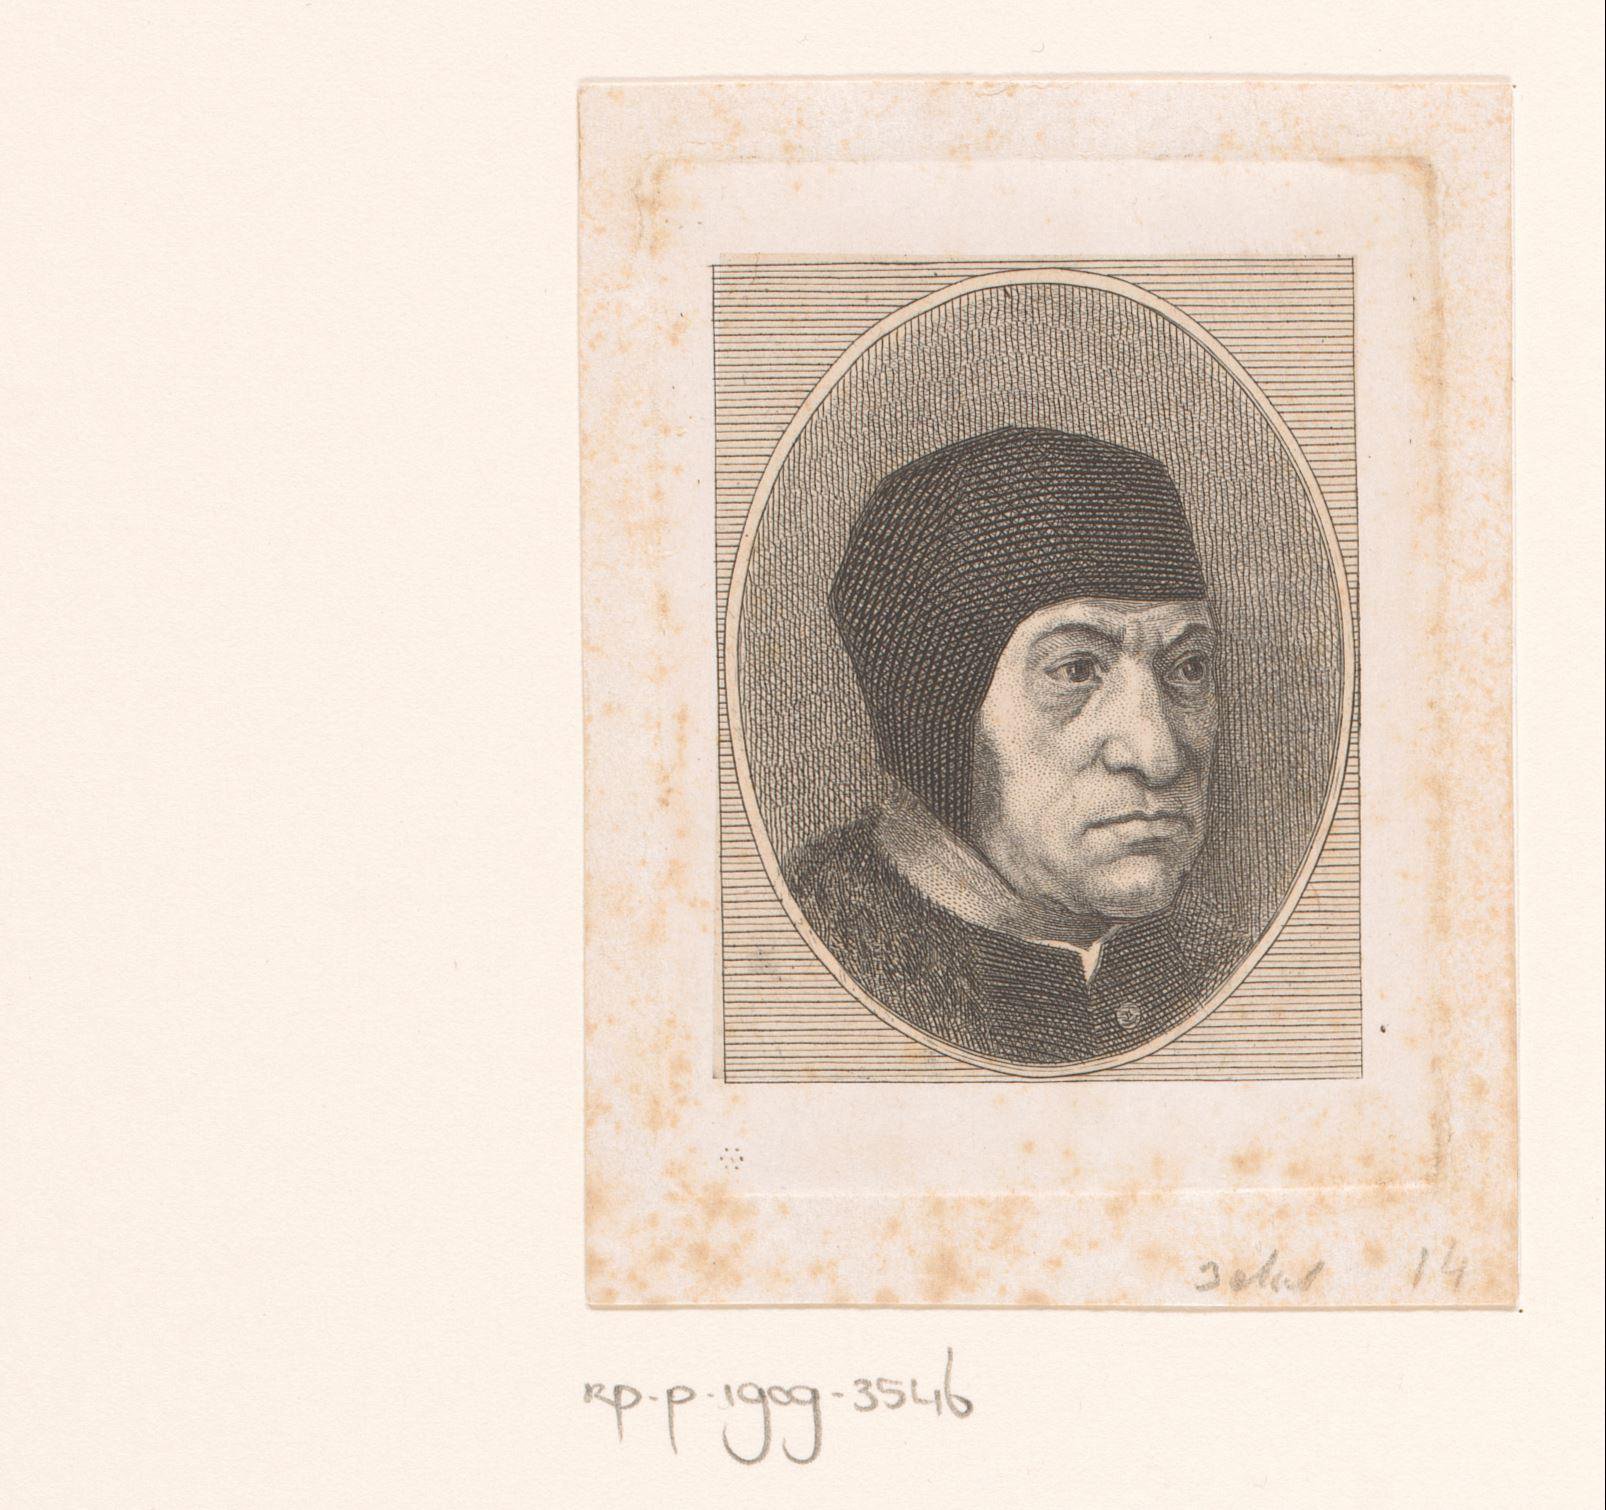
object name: print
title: Portret van Philips Haneton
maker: auguste danse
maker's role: print maker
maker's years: 1829-1929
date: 1839-1874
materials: paper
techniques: engraving, etching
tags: historical person (...) - historical person (...) portrayed alone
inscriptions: annotation: ‘3 etat’, collector's mark: Lugt 2228, annotation: ‘3 epr.’